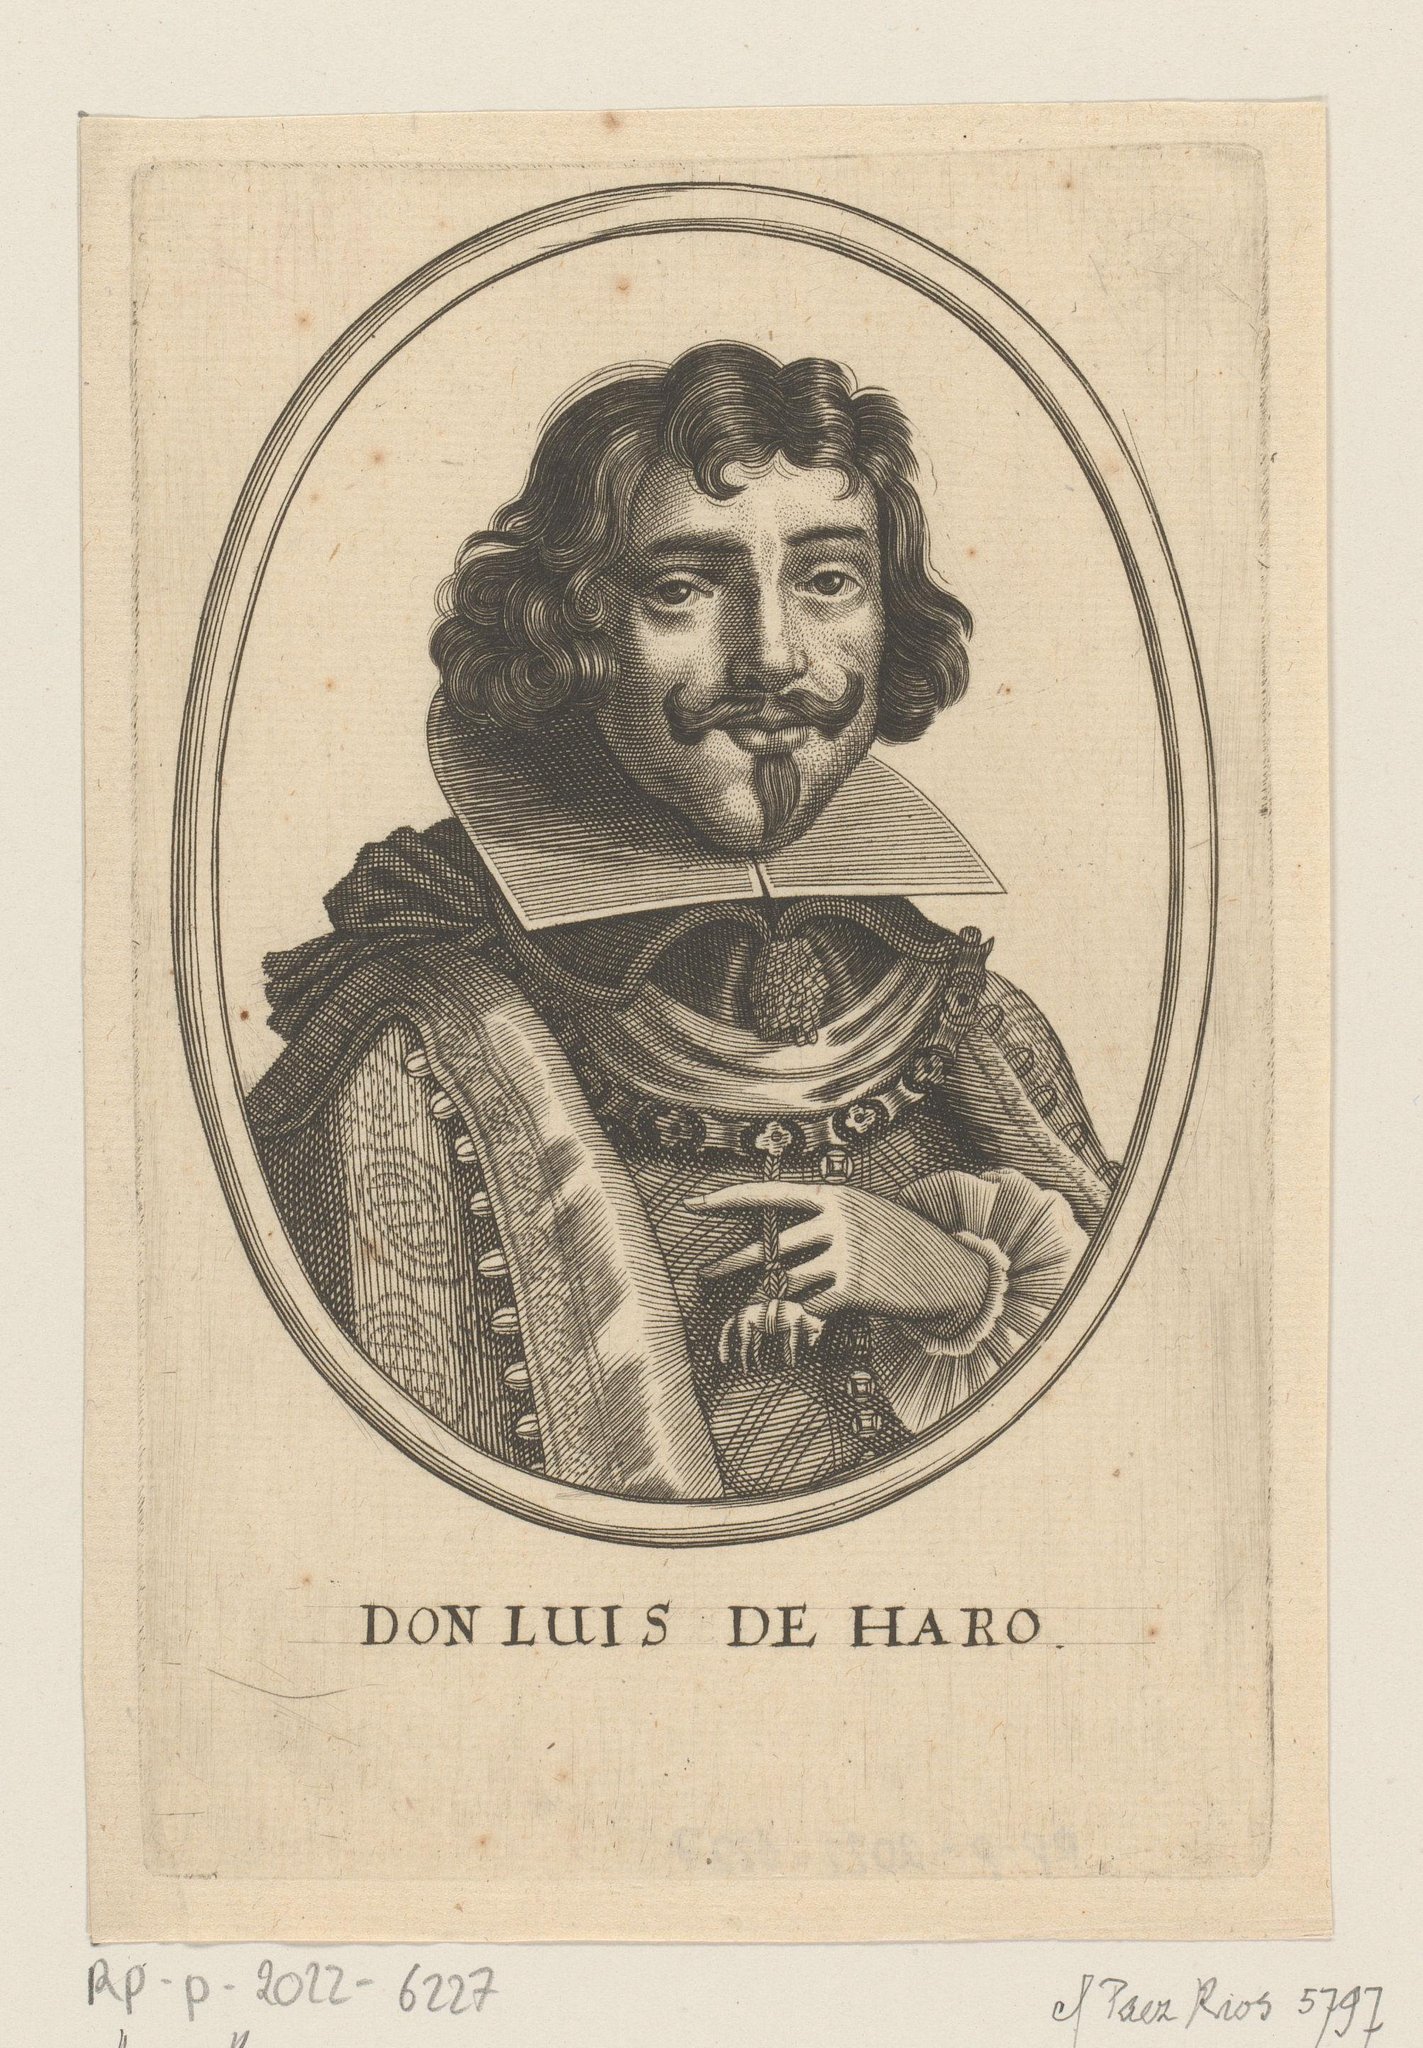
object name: print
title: Portret van Luis Méndez de Haro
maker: Anonymous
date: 1606-1686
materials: paper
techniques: engraving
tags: politician, commander-in-chief, general, marshal, historical persons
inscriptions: number: ‘597’